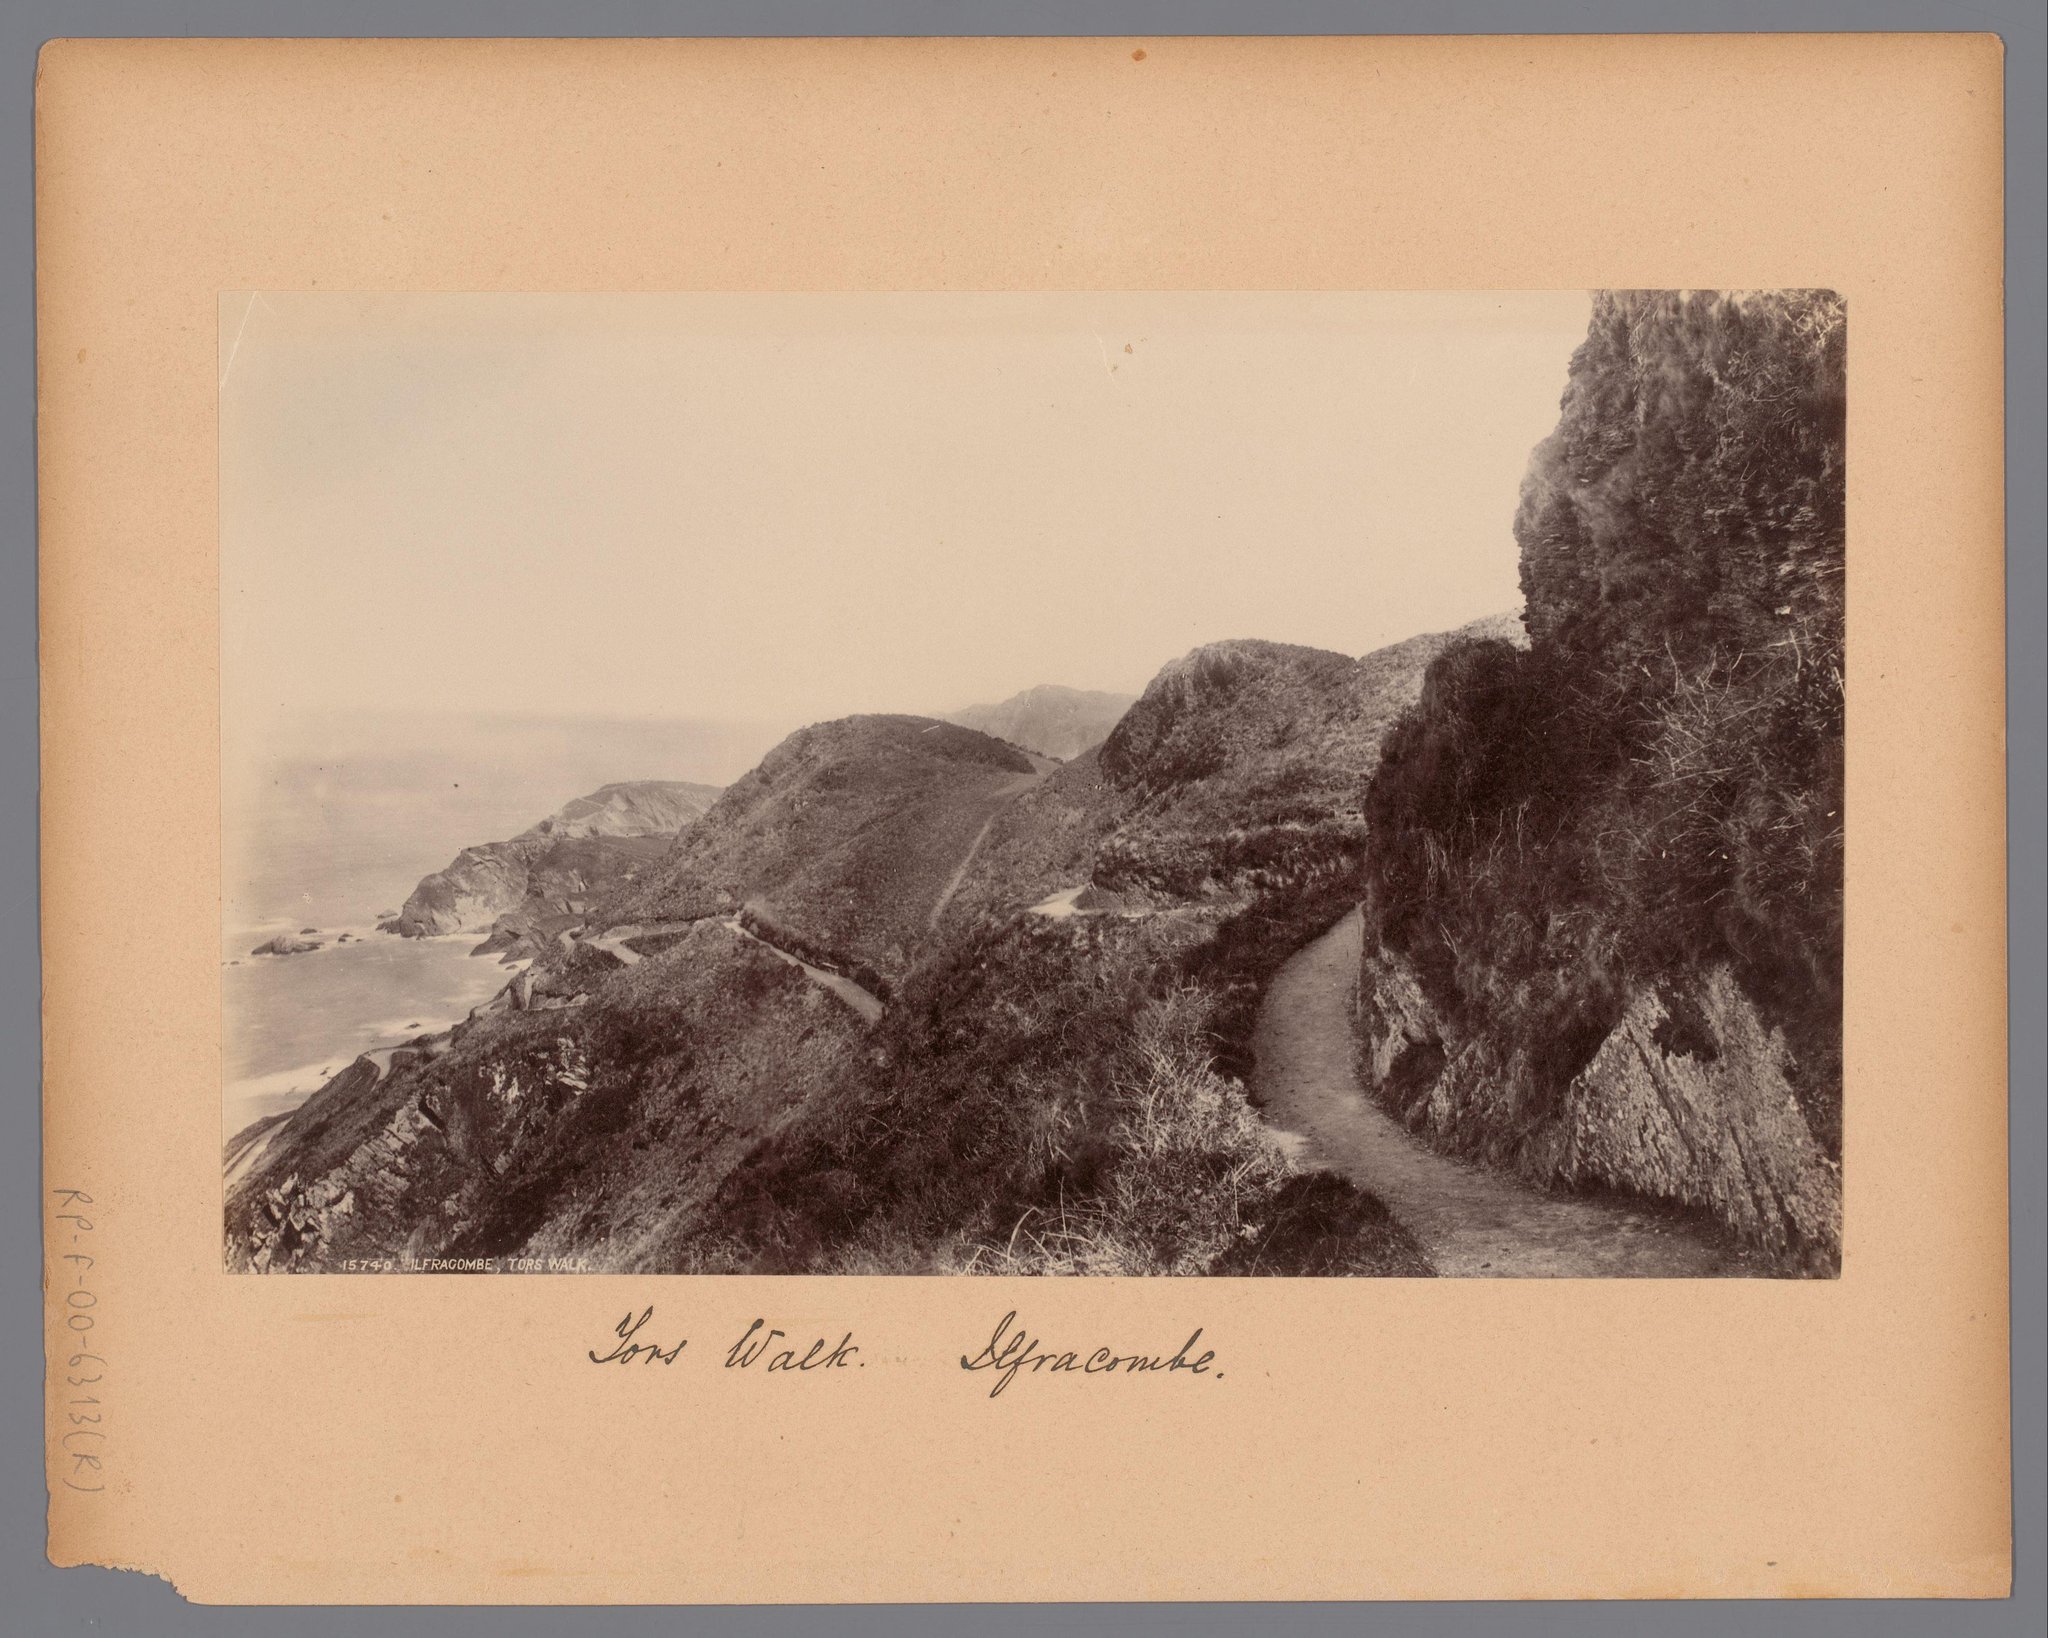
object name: album leaf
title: Torrs Walk, Ilfracombe, Devon, Engeland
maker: francis frith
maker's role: publisher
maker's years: 1822-1898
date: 1870-1890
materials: cardboard, paper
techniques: albumen print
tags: devon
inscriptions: inscription: ‘Tors [sic] Walk, Ilfracombe.’, check stamp: ‘FRITH S SERIES’, inscription: ‘15740 ILFRACOMBE, TORS WALK.’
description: Ilfracombe is een stad aan zee en omgeven door cliffs aan de noordkust van Engeland, in de provincie Devon.